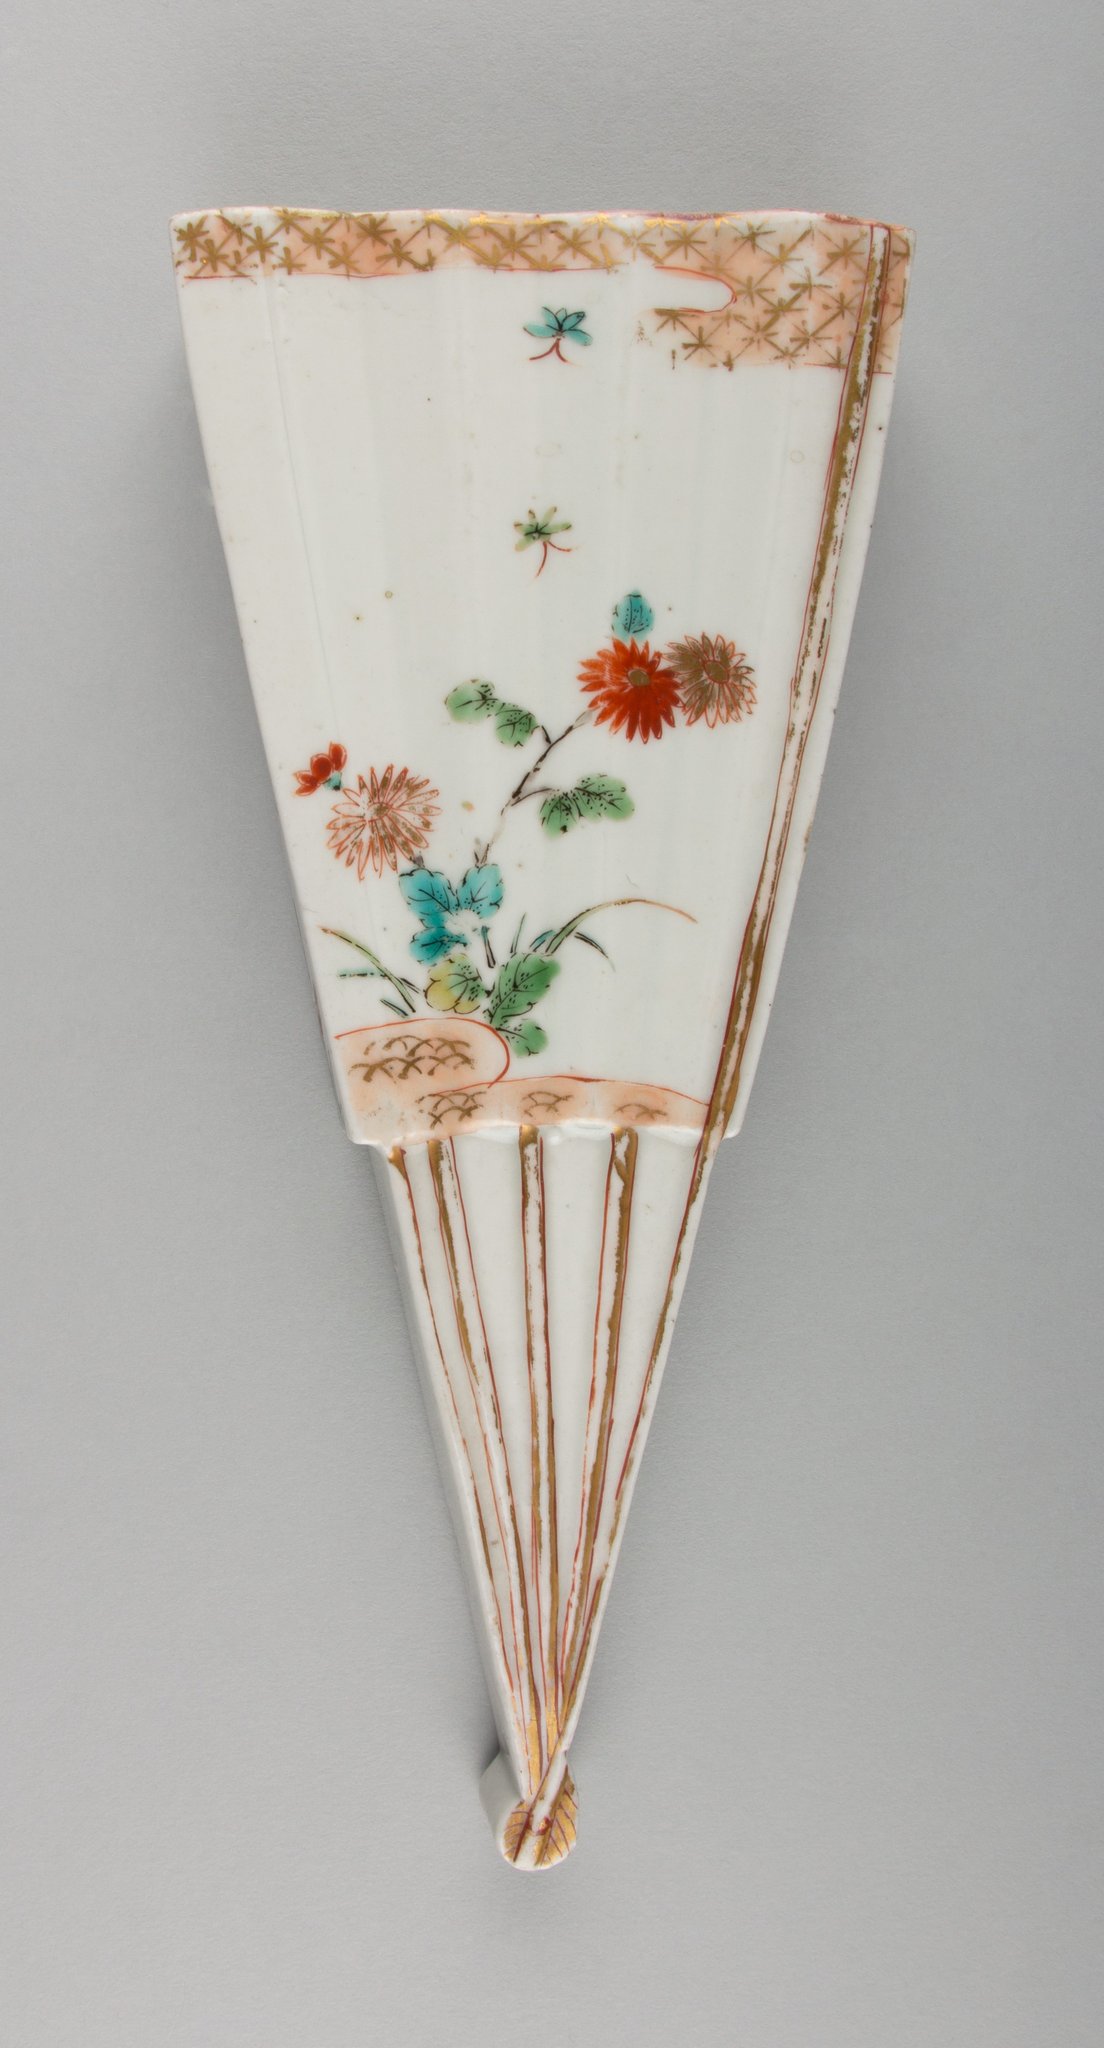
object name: wall vase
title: One of a Pair of Fan-Shaped Hanging Wall Vases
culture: japanese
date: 1667-1700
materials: enamel, gold, porcelain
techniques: overglaze